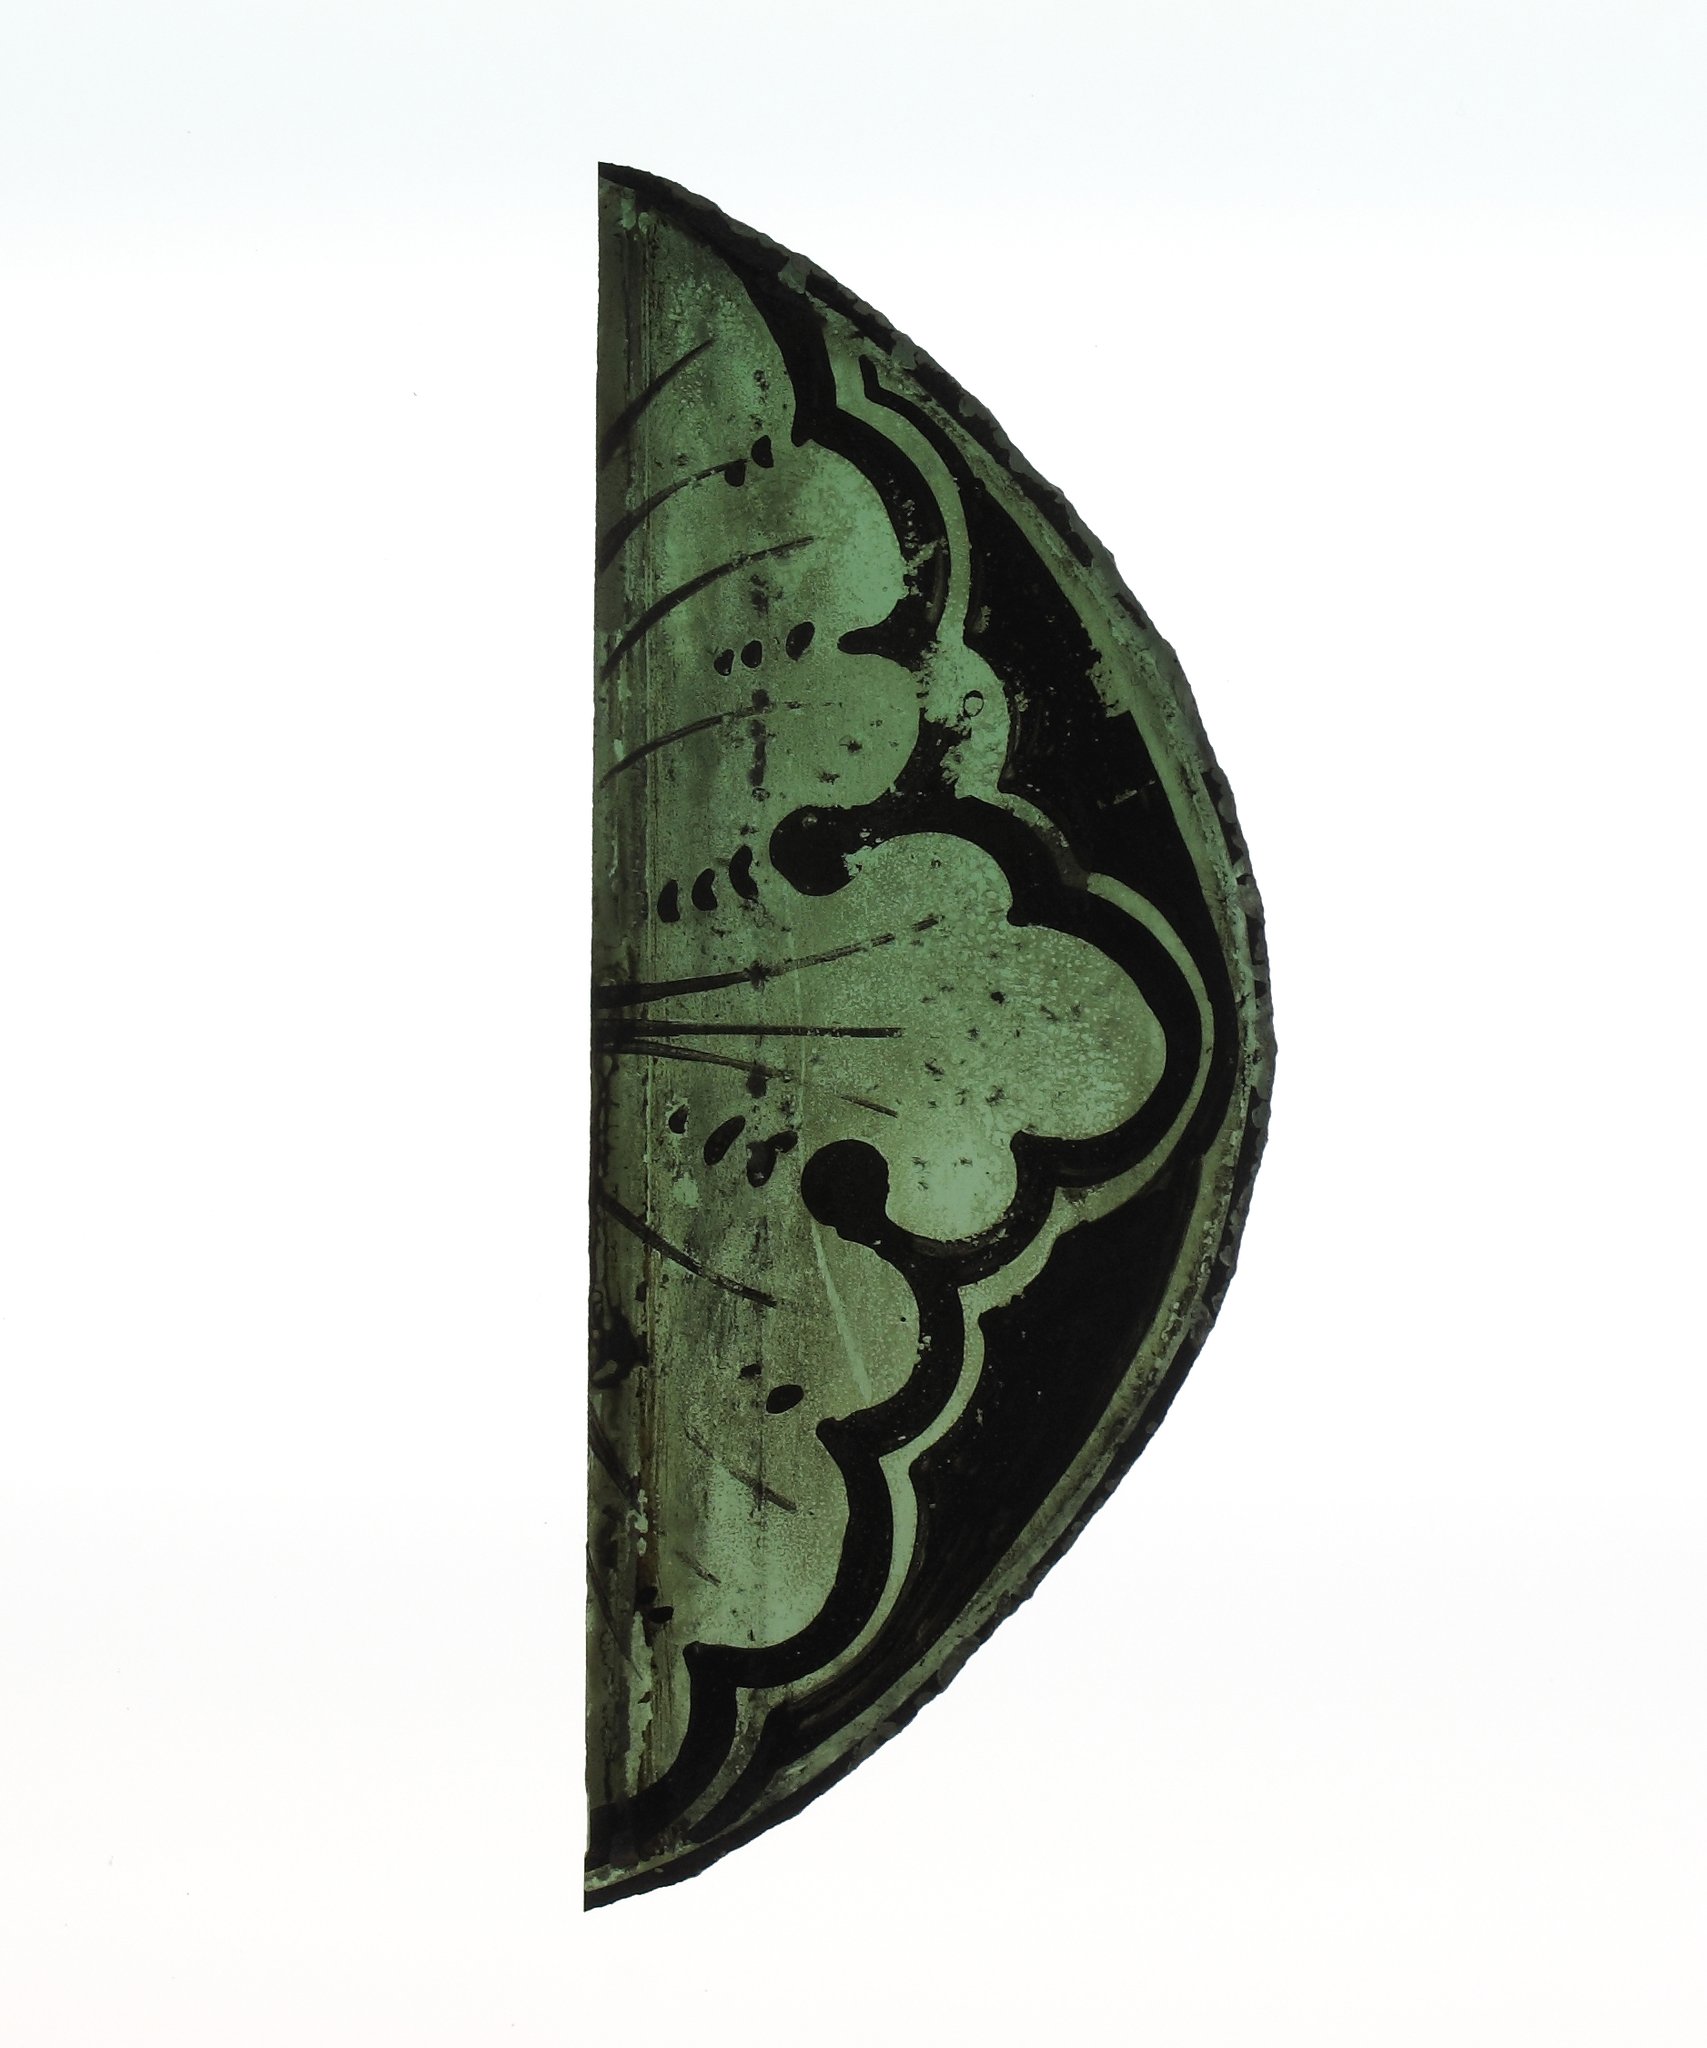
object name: panel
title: Grisaille Panel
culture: french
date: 1325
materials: glass, metal, paint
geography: france